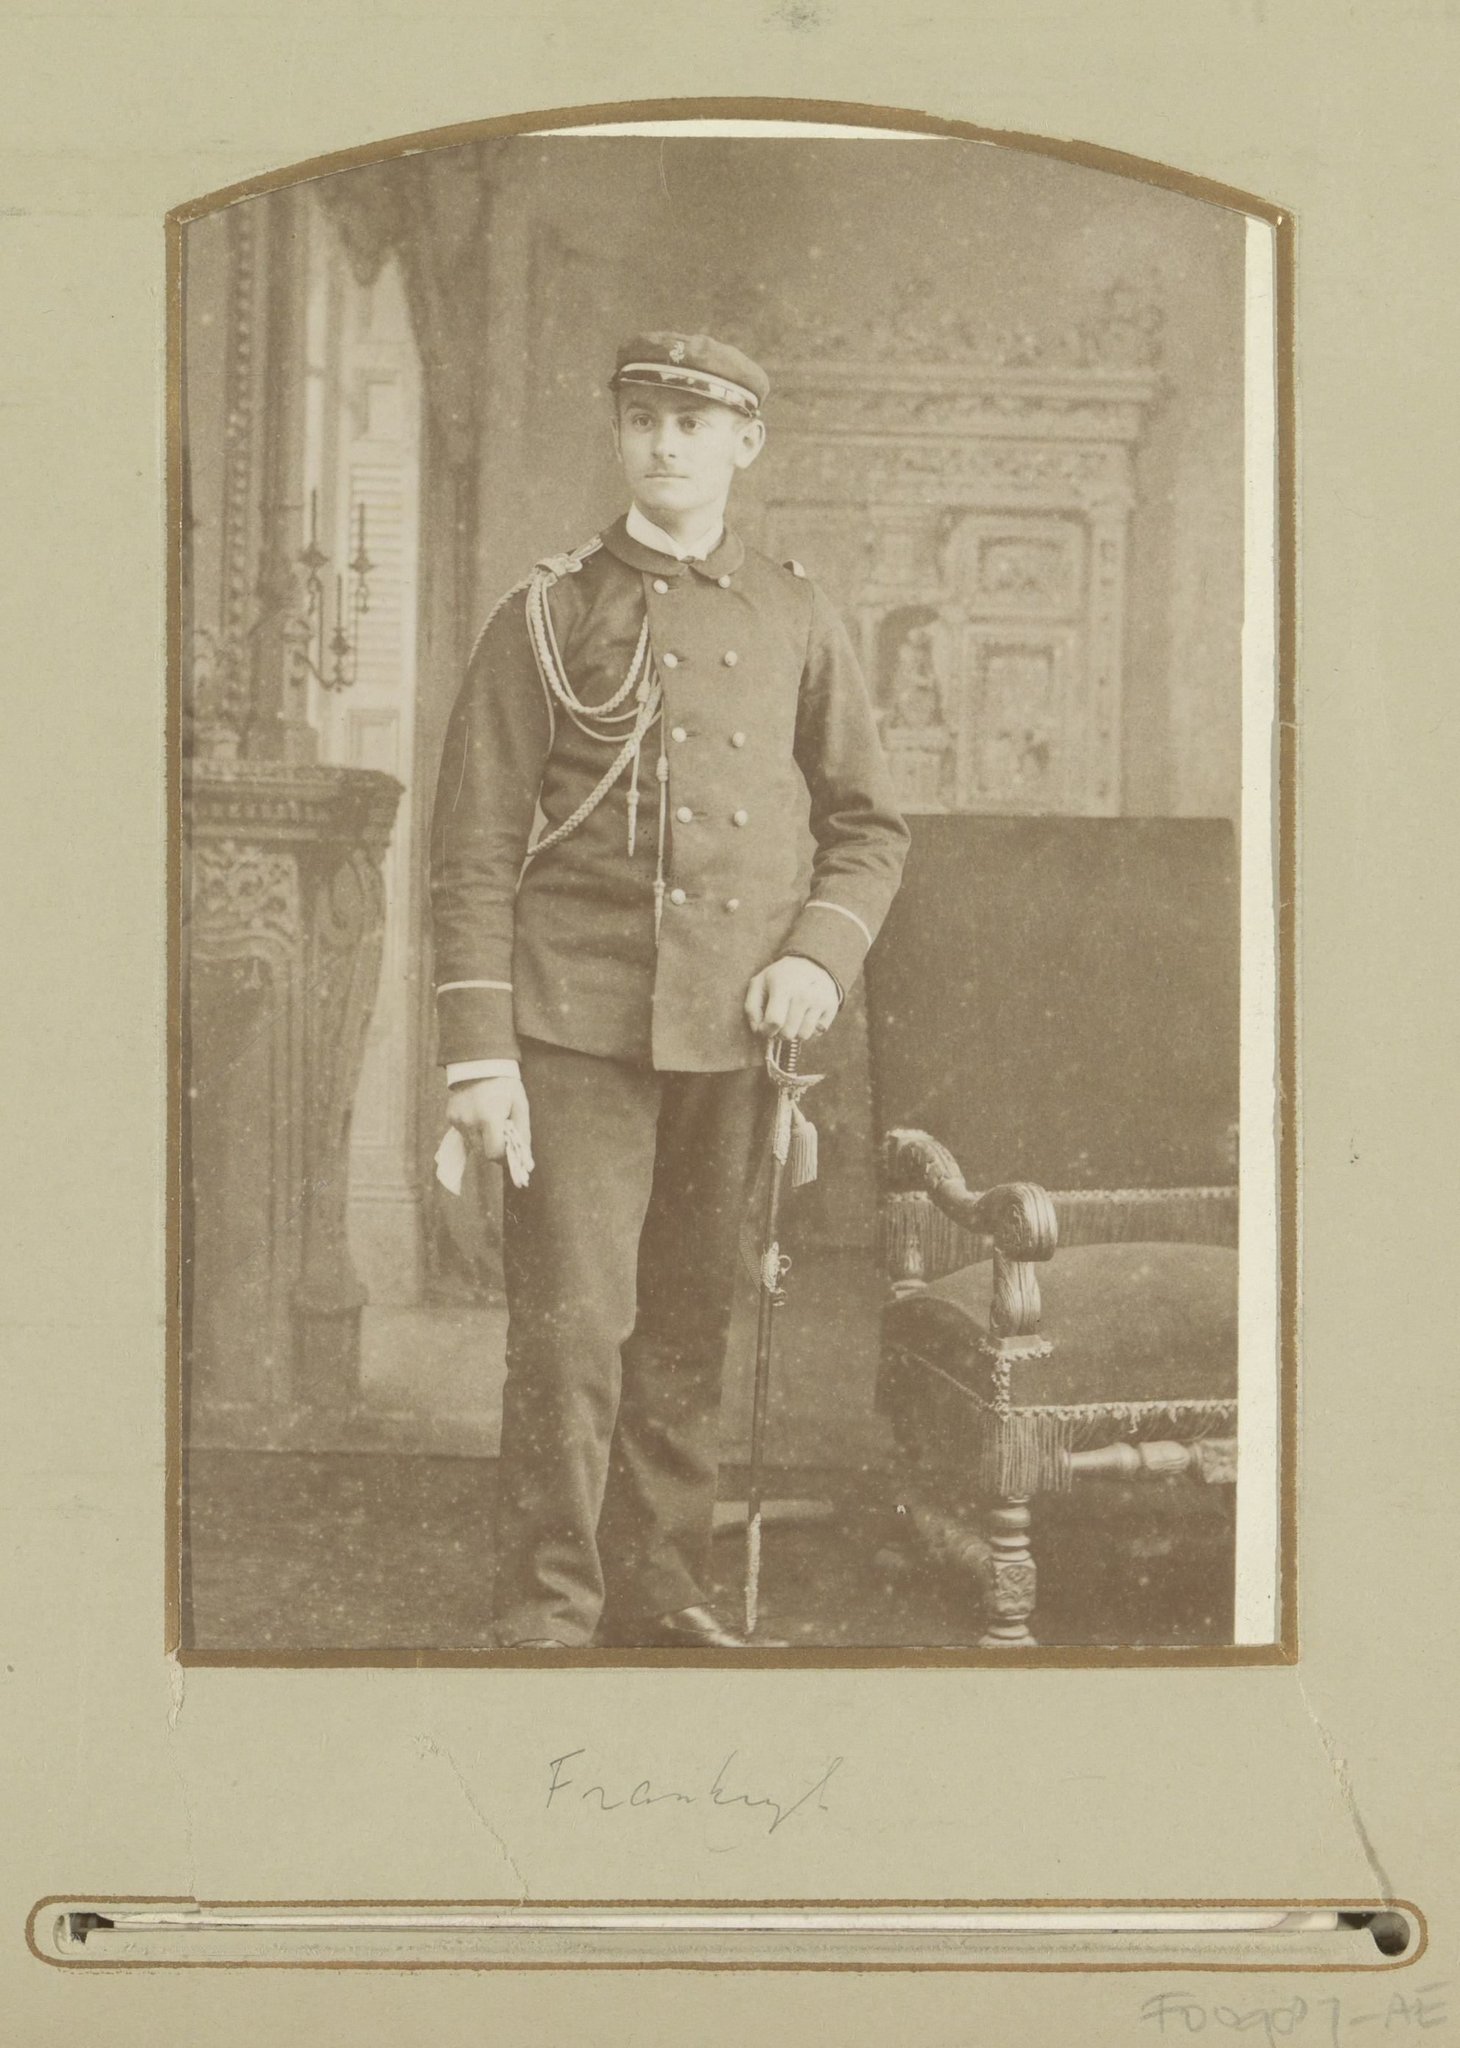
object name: album leaf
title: Portret van een (vermoedelijk) Franse militair, staand bij een fauteuil met sabel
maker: jules alexandre joseph delzor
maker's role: fotograaf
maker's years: 1841-1902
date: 1870-1900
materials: cardboard, paper, photographic support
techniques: albumen print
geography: epernay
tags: studio requisites ~ photographer, hacking and thrusting weapons (with name), warfare; military affairs, (military) uniforms, division of armed forces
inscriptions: address: ‘19, Rue Gambetta, Épernay’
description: Onderdeel van Album met cartes-de-visite en kabinetfoto's van militairen in uniform.